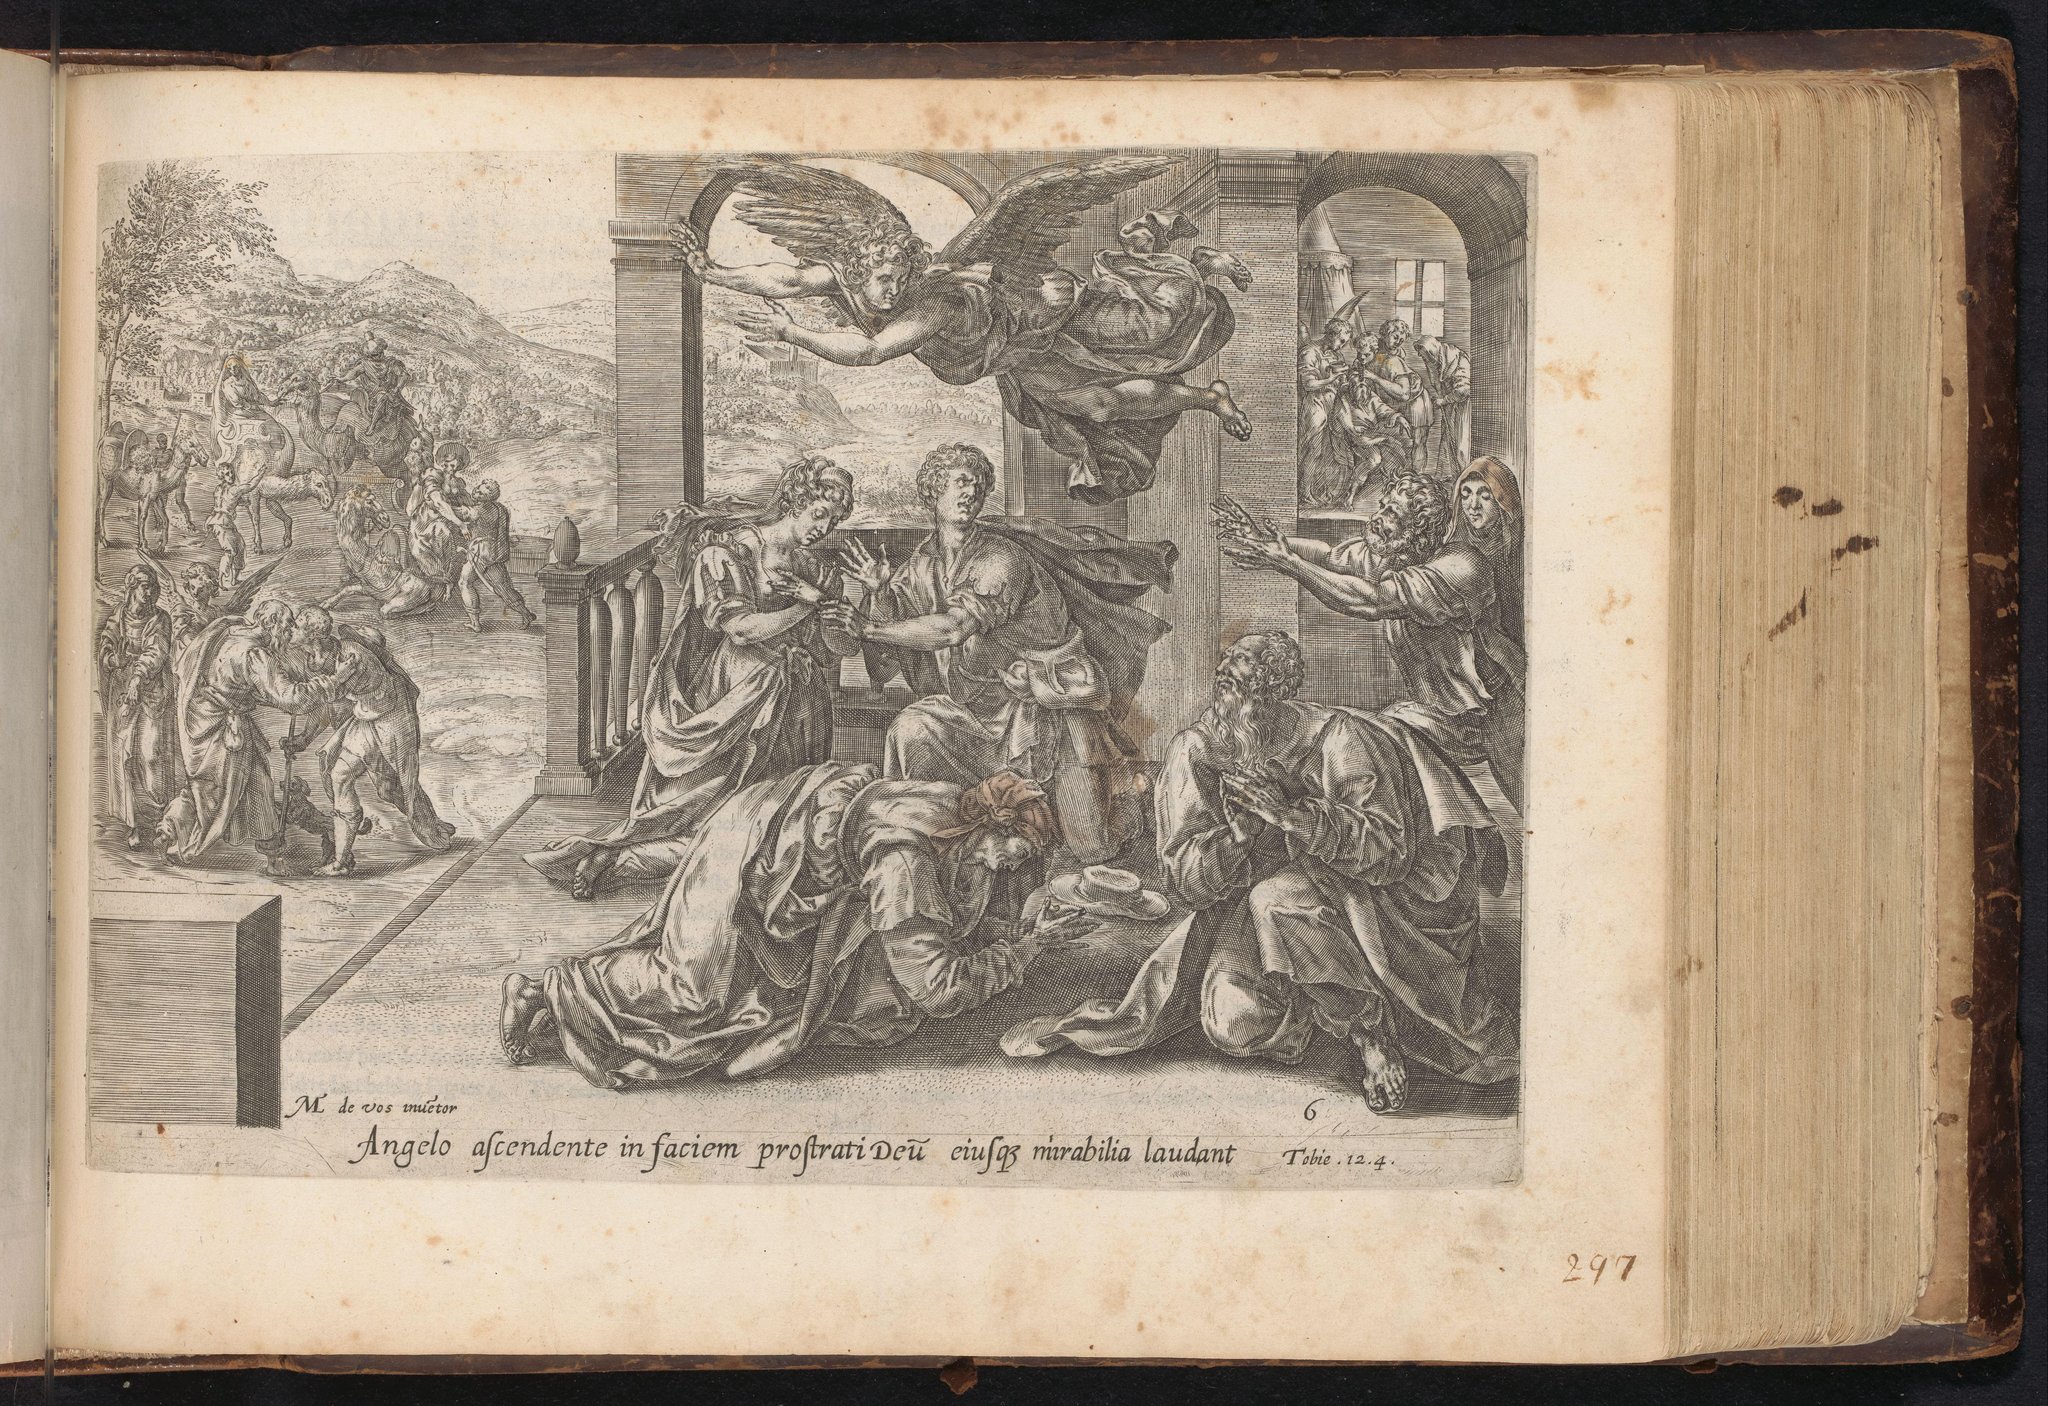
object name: print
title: Den Grooten Figuer-Bibel (...)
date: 1585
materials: paper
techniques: engraving, hand coloring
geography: alkmaar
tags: the angel raphael disappears into the sky, sarah's arrival ~ tobias' return, the meeting of parents and son ~ tobias' return, the healing of tobit: tobias puts the gall of the fish on his father's eyes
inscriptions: number: ‘297’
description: De engel Rafaël maakt zich bekend aan Tobit, Anna, Tobias en Sara. Zij knielen op de grond. Tobit is teruggekeerd naar huis en wordt links ontvangen door zijn ouders Tobit en Anna. Nog verder op de achtergrond de ontvangst van Tobias' vrouw Sara. Rechts in het huis de genezing van Tobit. Onder de voorstelling een verwijzing in het Latijn naar de Bijbeltekst in Tobit. 12:4. Deze prent maakt deel uit van een album.